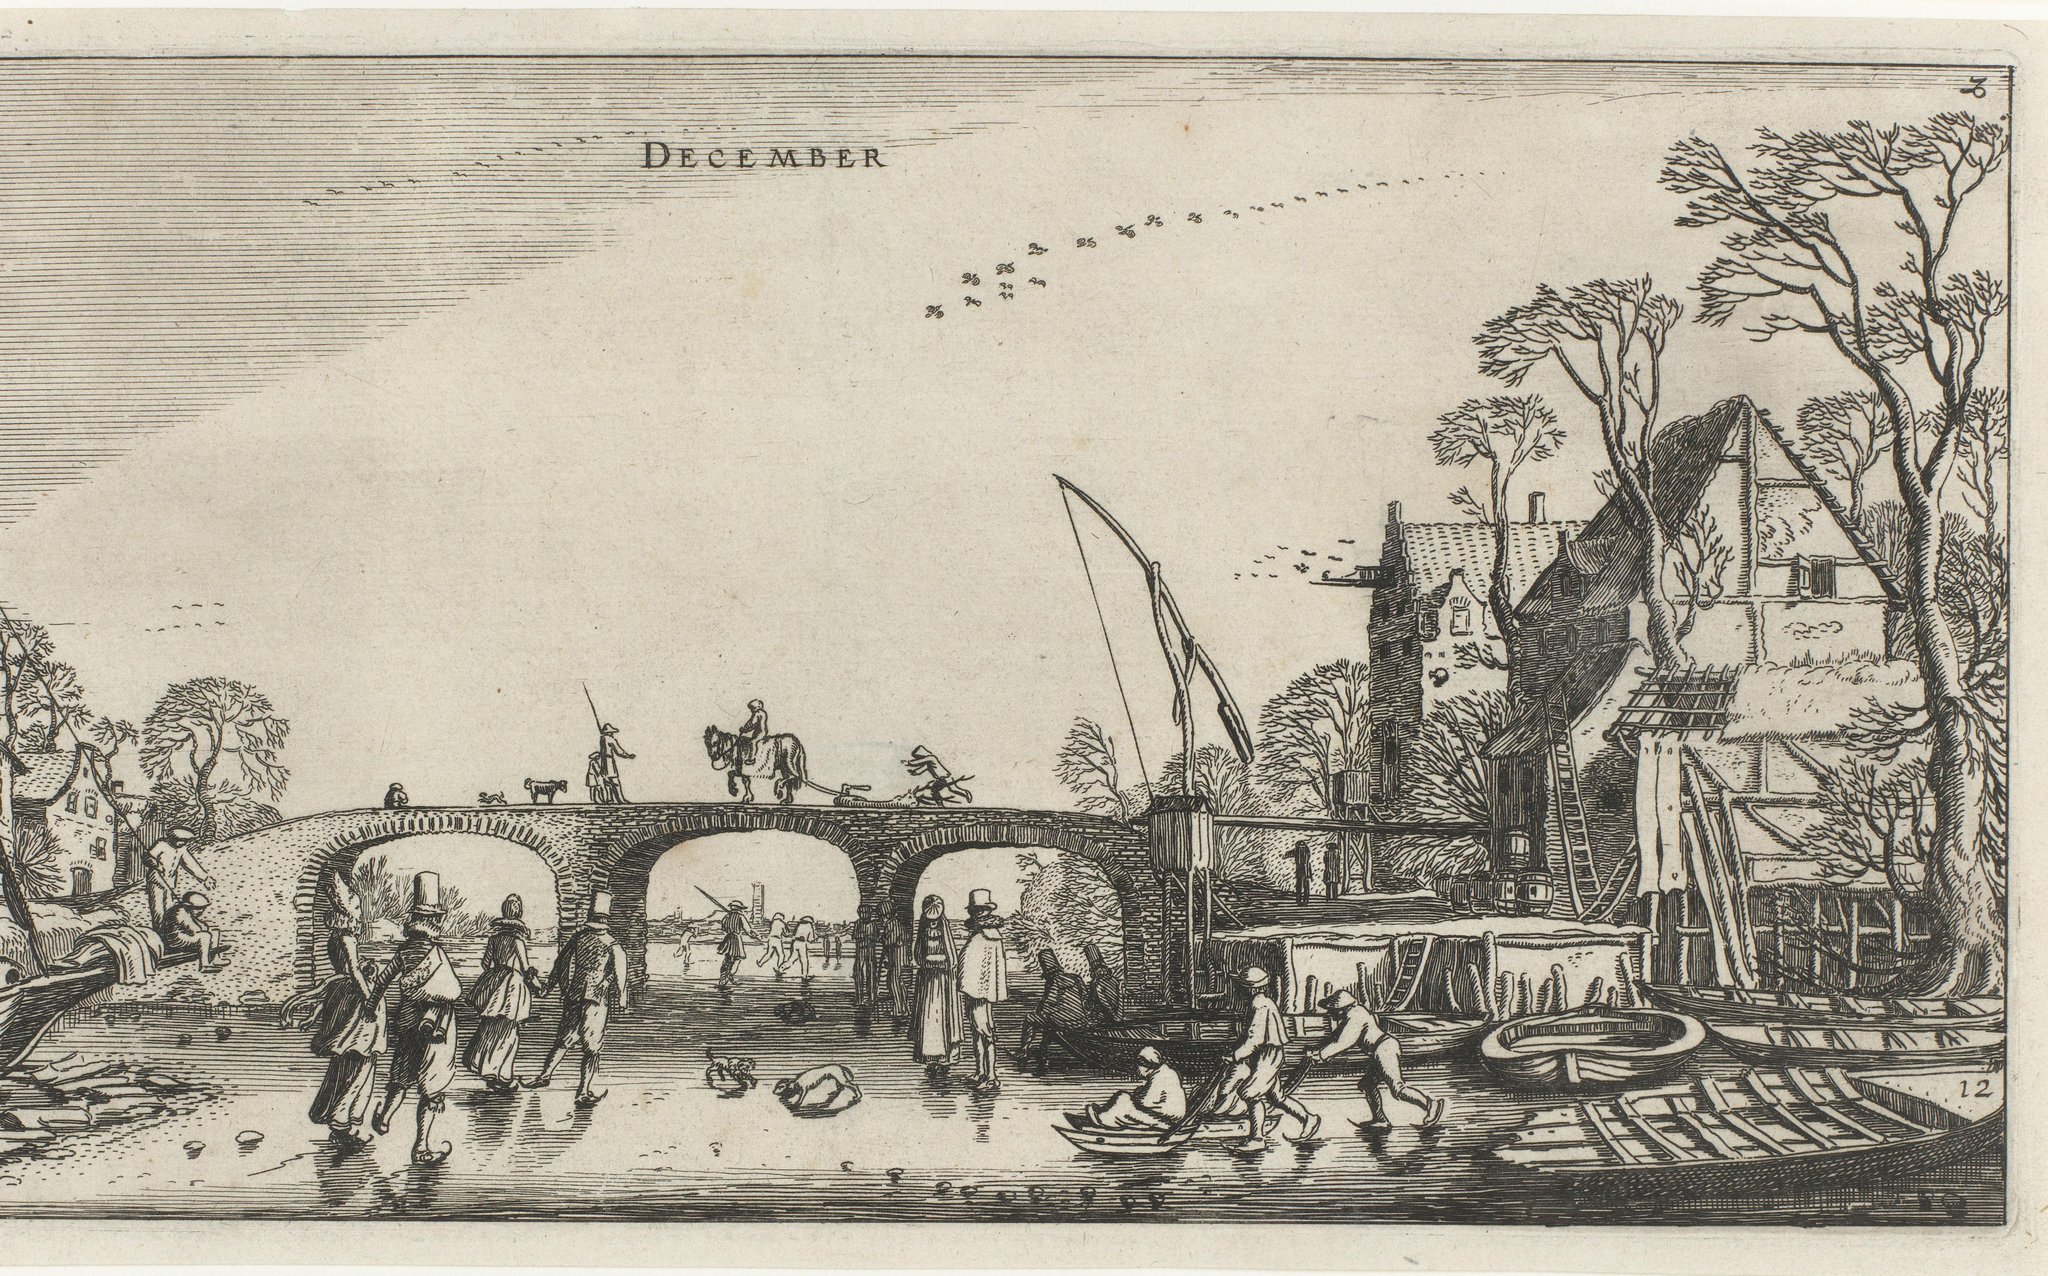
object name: print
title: December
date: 1616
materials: paper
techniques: etching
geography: northern netherlands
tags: landscape symbolizing december, skates (winter sports), bridge in city across river, canal, etc., capricorn (zodiacal sign of december)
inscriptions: collector's mark: Lugt 698, collector's mark: Lugt 345, collector's mark: Lugt 964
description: Gezicht op een dorp met een stenen brug, met op de voorgrond schaatsenrijders op het ijs, voorstellende de maand december. Links- en rechtsboven de bij deze maand behorende symbolen van het sterrenbeeld steenbok. Twaalfde prent uit een serie van twaalf.